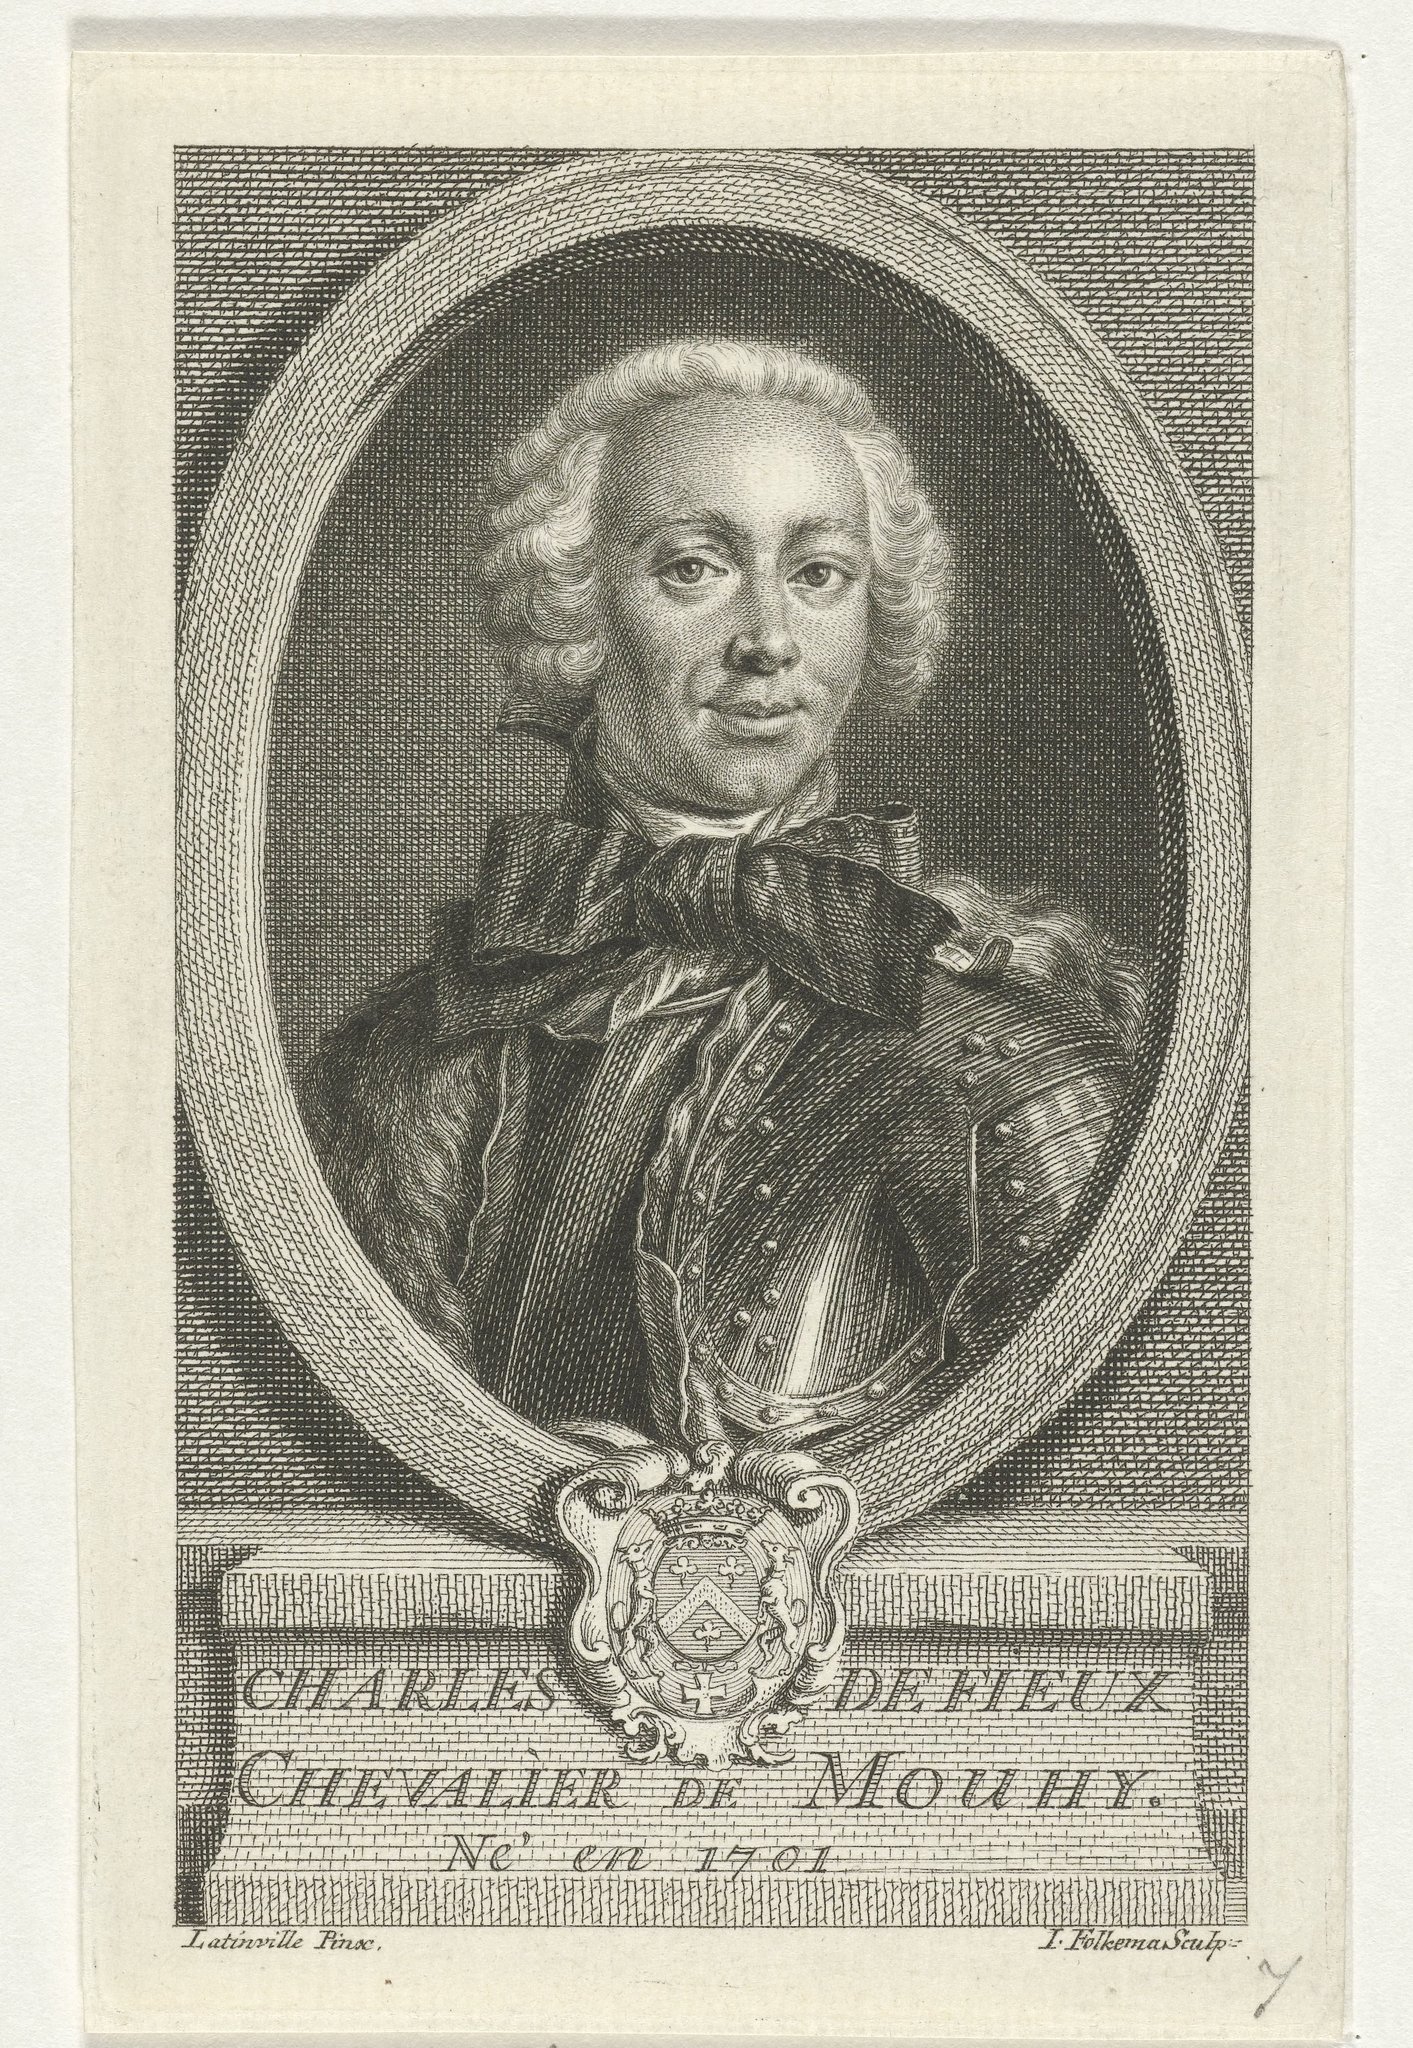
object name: print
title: Portret van Charles de Fieux de Mouhy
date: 1702-1767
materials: paper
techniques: engraving, etching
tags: paris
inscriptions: number: ‘7’, collector's mark: Lugt 240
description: Portretbuste in ovaal naar links van de Franse schrijver Charles de Fieux de Mouhy, blootshoofds. Het portret staat op een met wapenschild getooide sokkel waarop de naam en het geboortejaar van de geportretteerde.